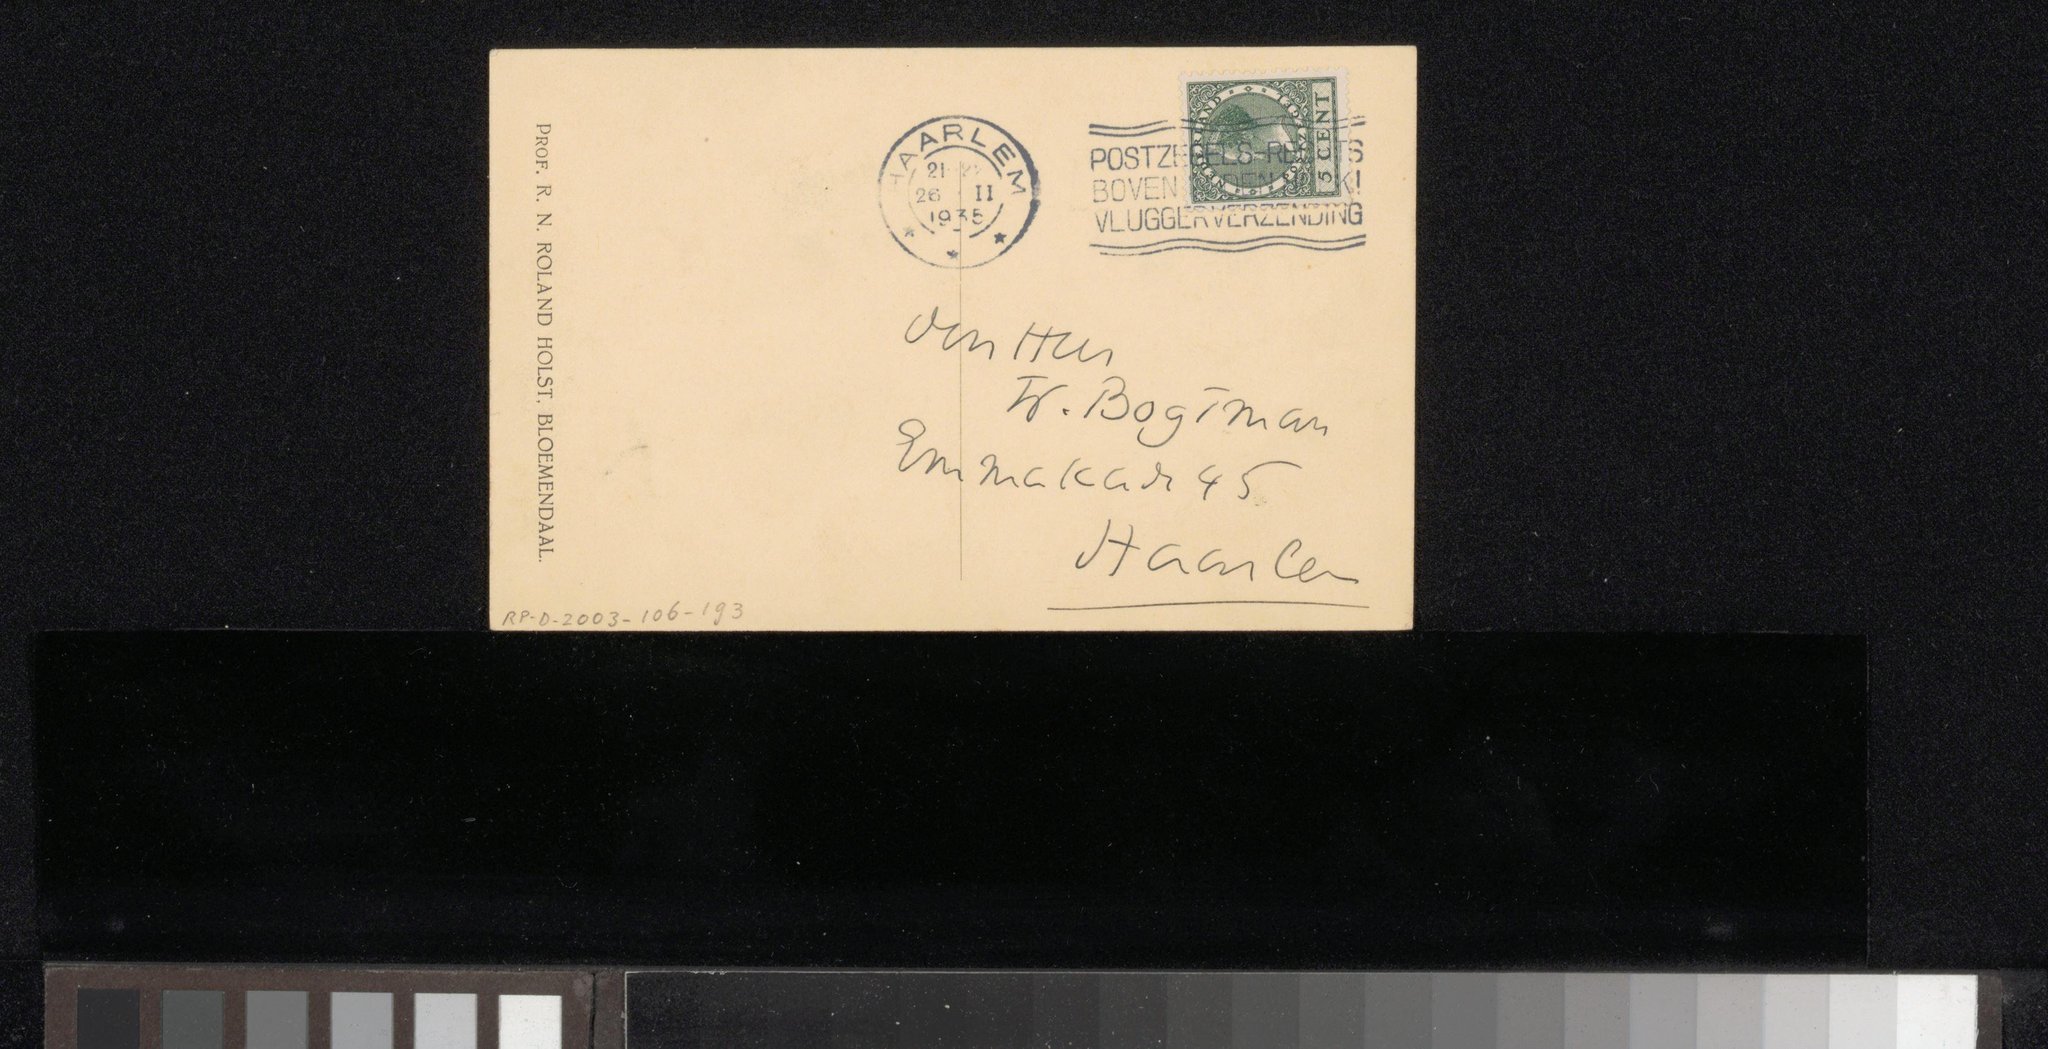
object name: postcard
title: Briefkaart aan Willem Bogtman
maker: richard nicolaüs roland holst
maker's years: 1868-1938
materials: cardboard, ink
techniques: pen, printing, writing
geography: haarlem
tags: ab bogtman, willem bogtman, drawing, applied arts, arts and crafts; industrial design